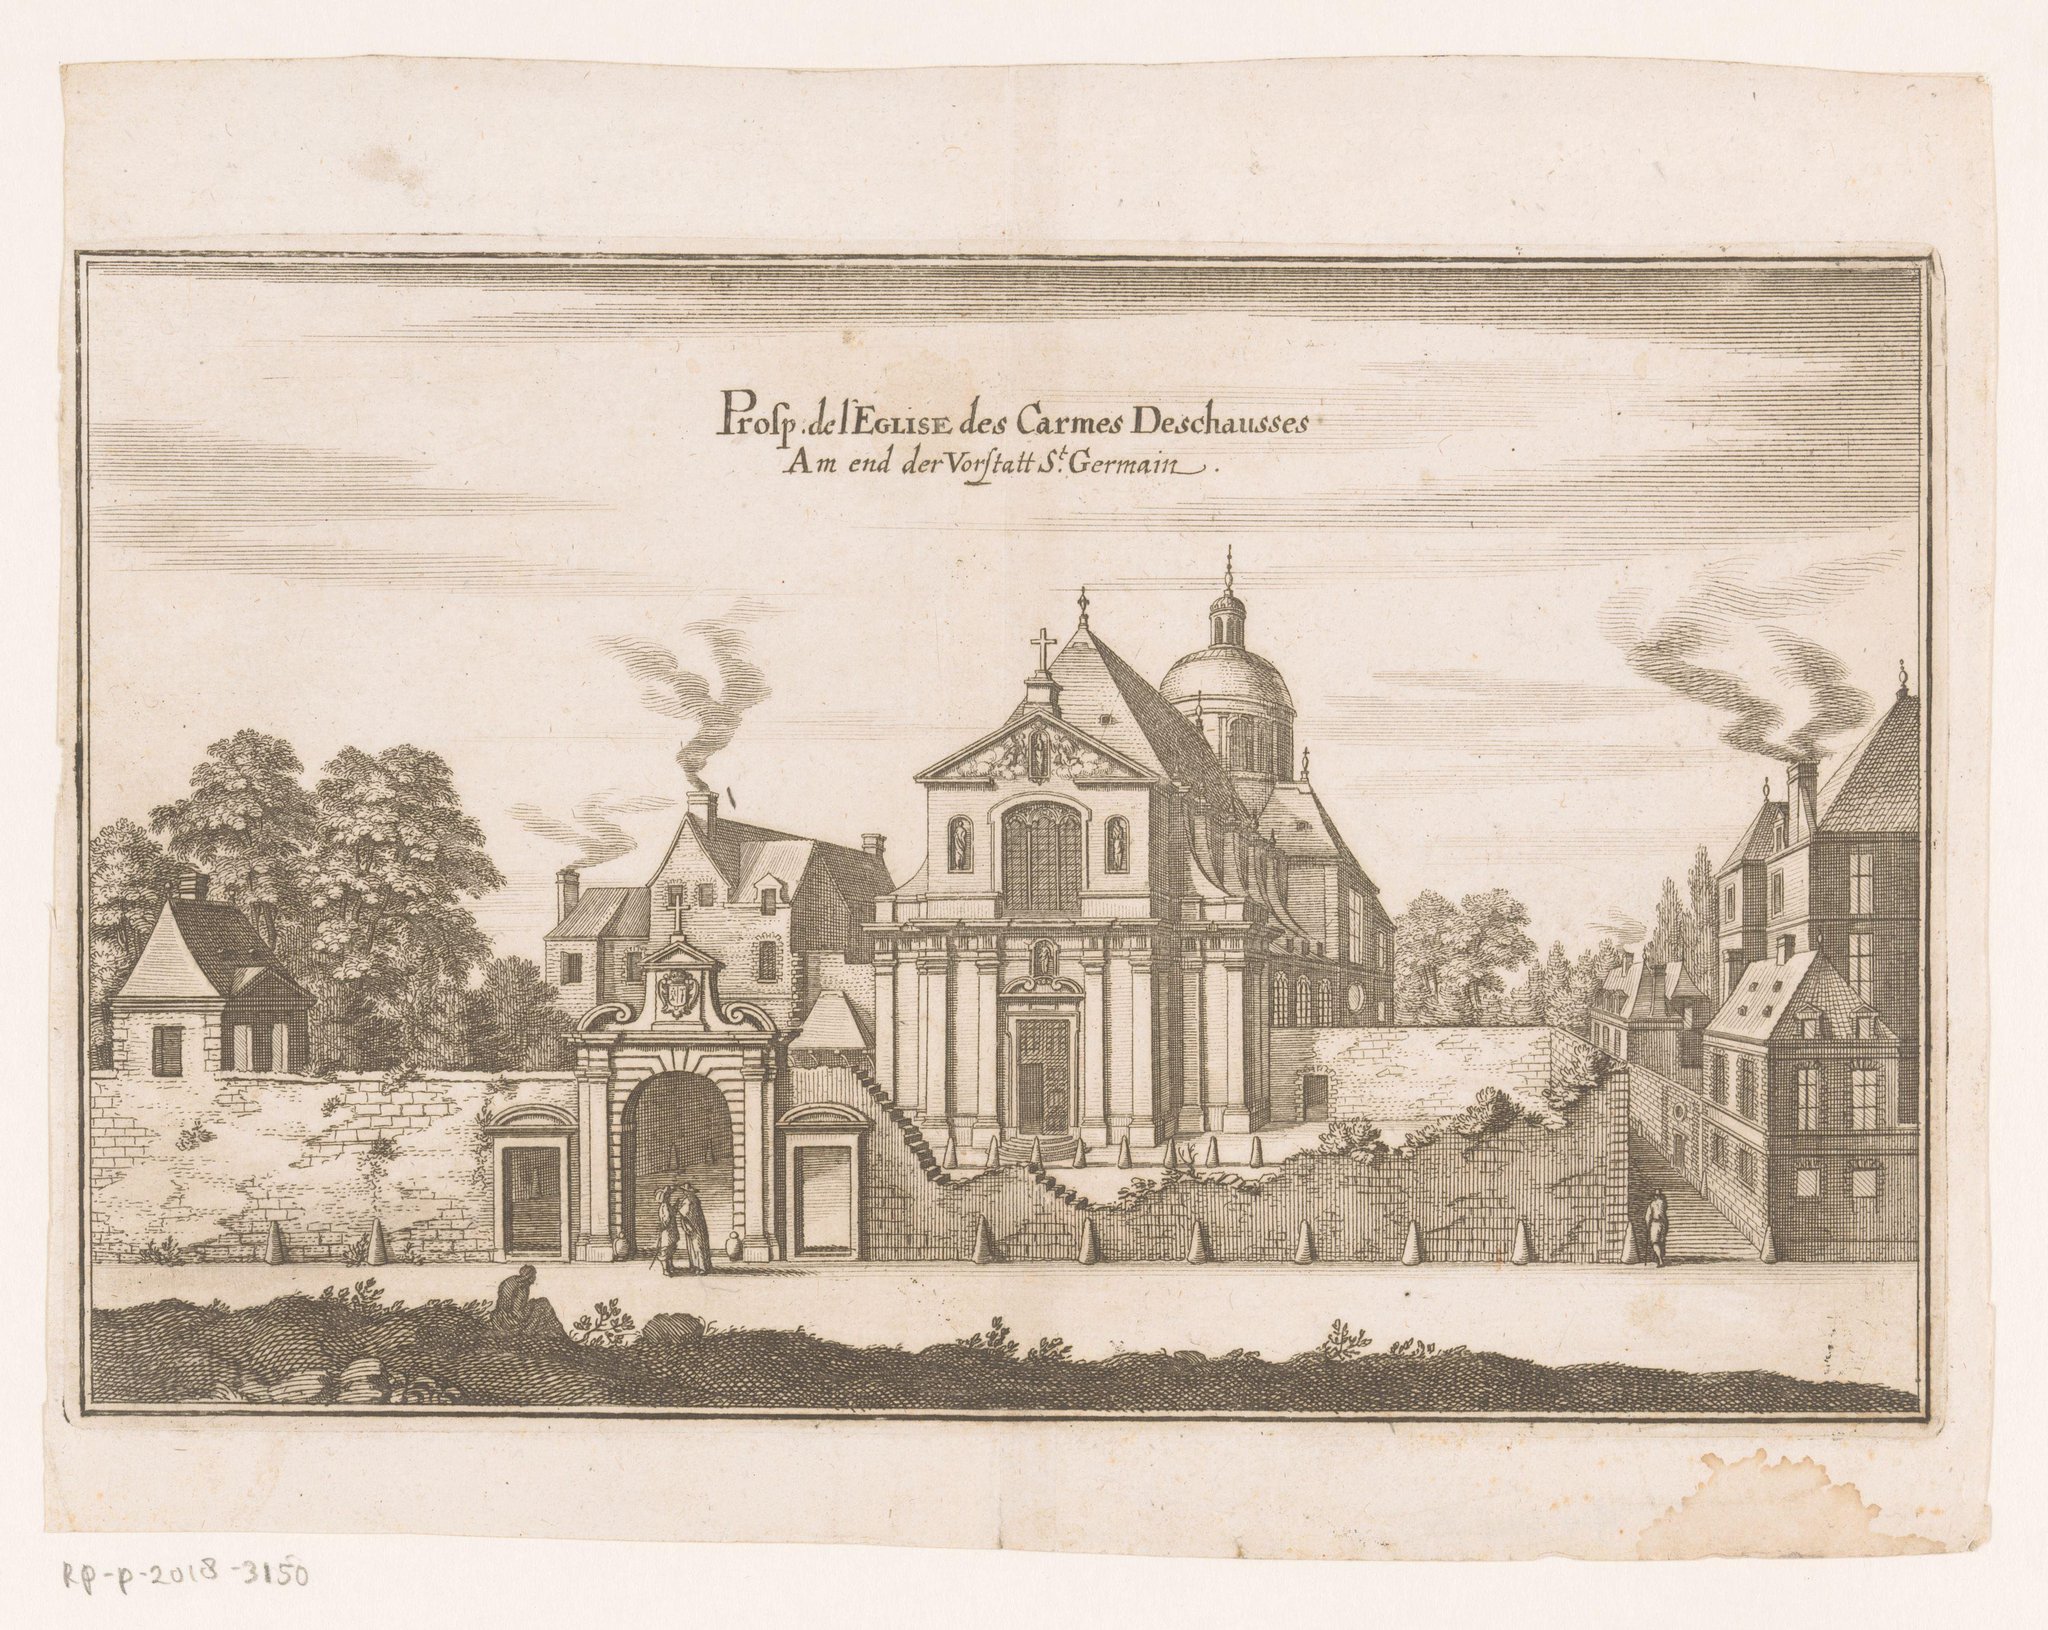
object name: print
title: Prosp. de l'Eglise des Carmes Deschausses Am end der Vorstatt St. Germain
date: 1655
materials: paper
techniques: engraving, etching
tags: abbey, monastery, convent ~ roman catholic church, church (exterior)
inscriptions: collector's mark: Lugt 2228